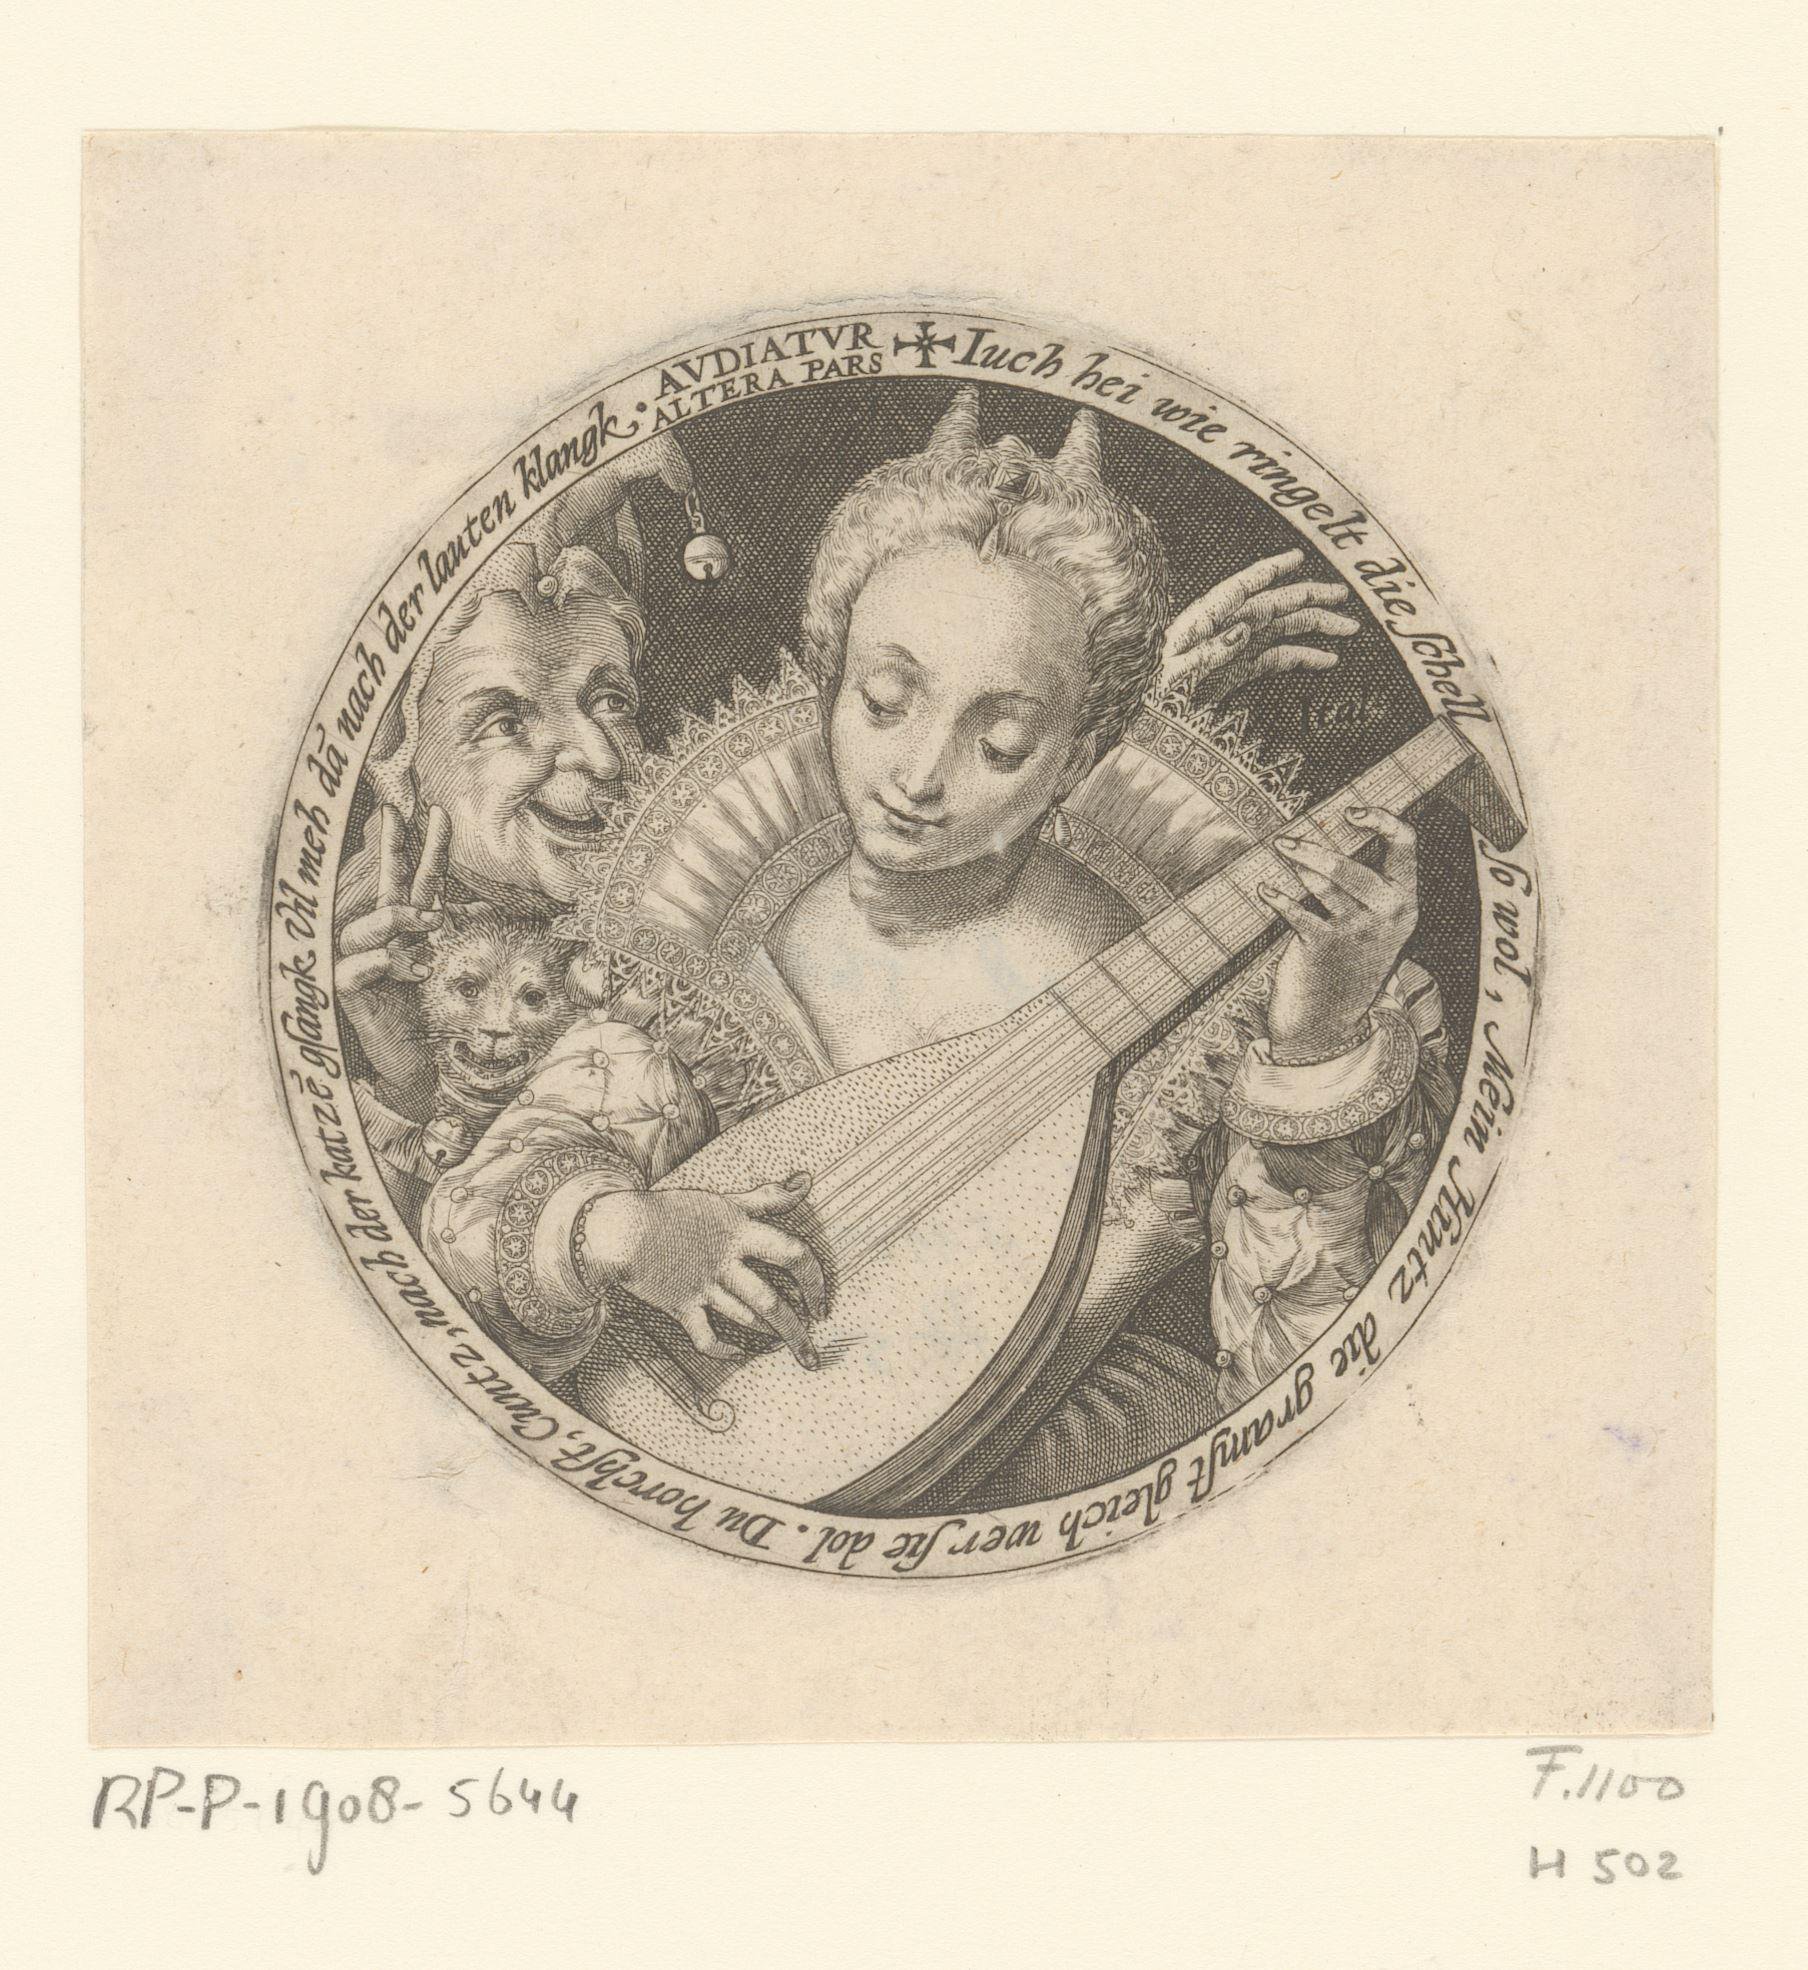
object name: print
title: Gehoor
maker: crispijn van de passe (i)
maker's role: draughtsman, print maker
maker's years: 1564-1637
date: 1589-1611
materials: paper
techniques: engraving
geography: cologne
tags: hearing, listening (one of the five senses), fool, simpleton, numskull, lute, and special forms of lute, e.g.: theorbo - cc - out of doors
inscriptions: collector's mark: Lugt 2228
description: De personificatie van het Gehoor, gekleed volgens de Italiaanse mode, de luit bespelend. Ze wordt vergezeld door een nar die een obsceen gebaar maakt en een miauwende kat. De omlijsting heeft een randschrift in het Duits en een motto in het Latijn.